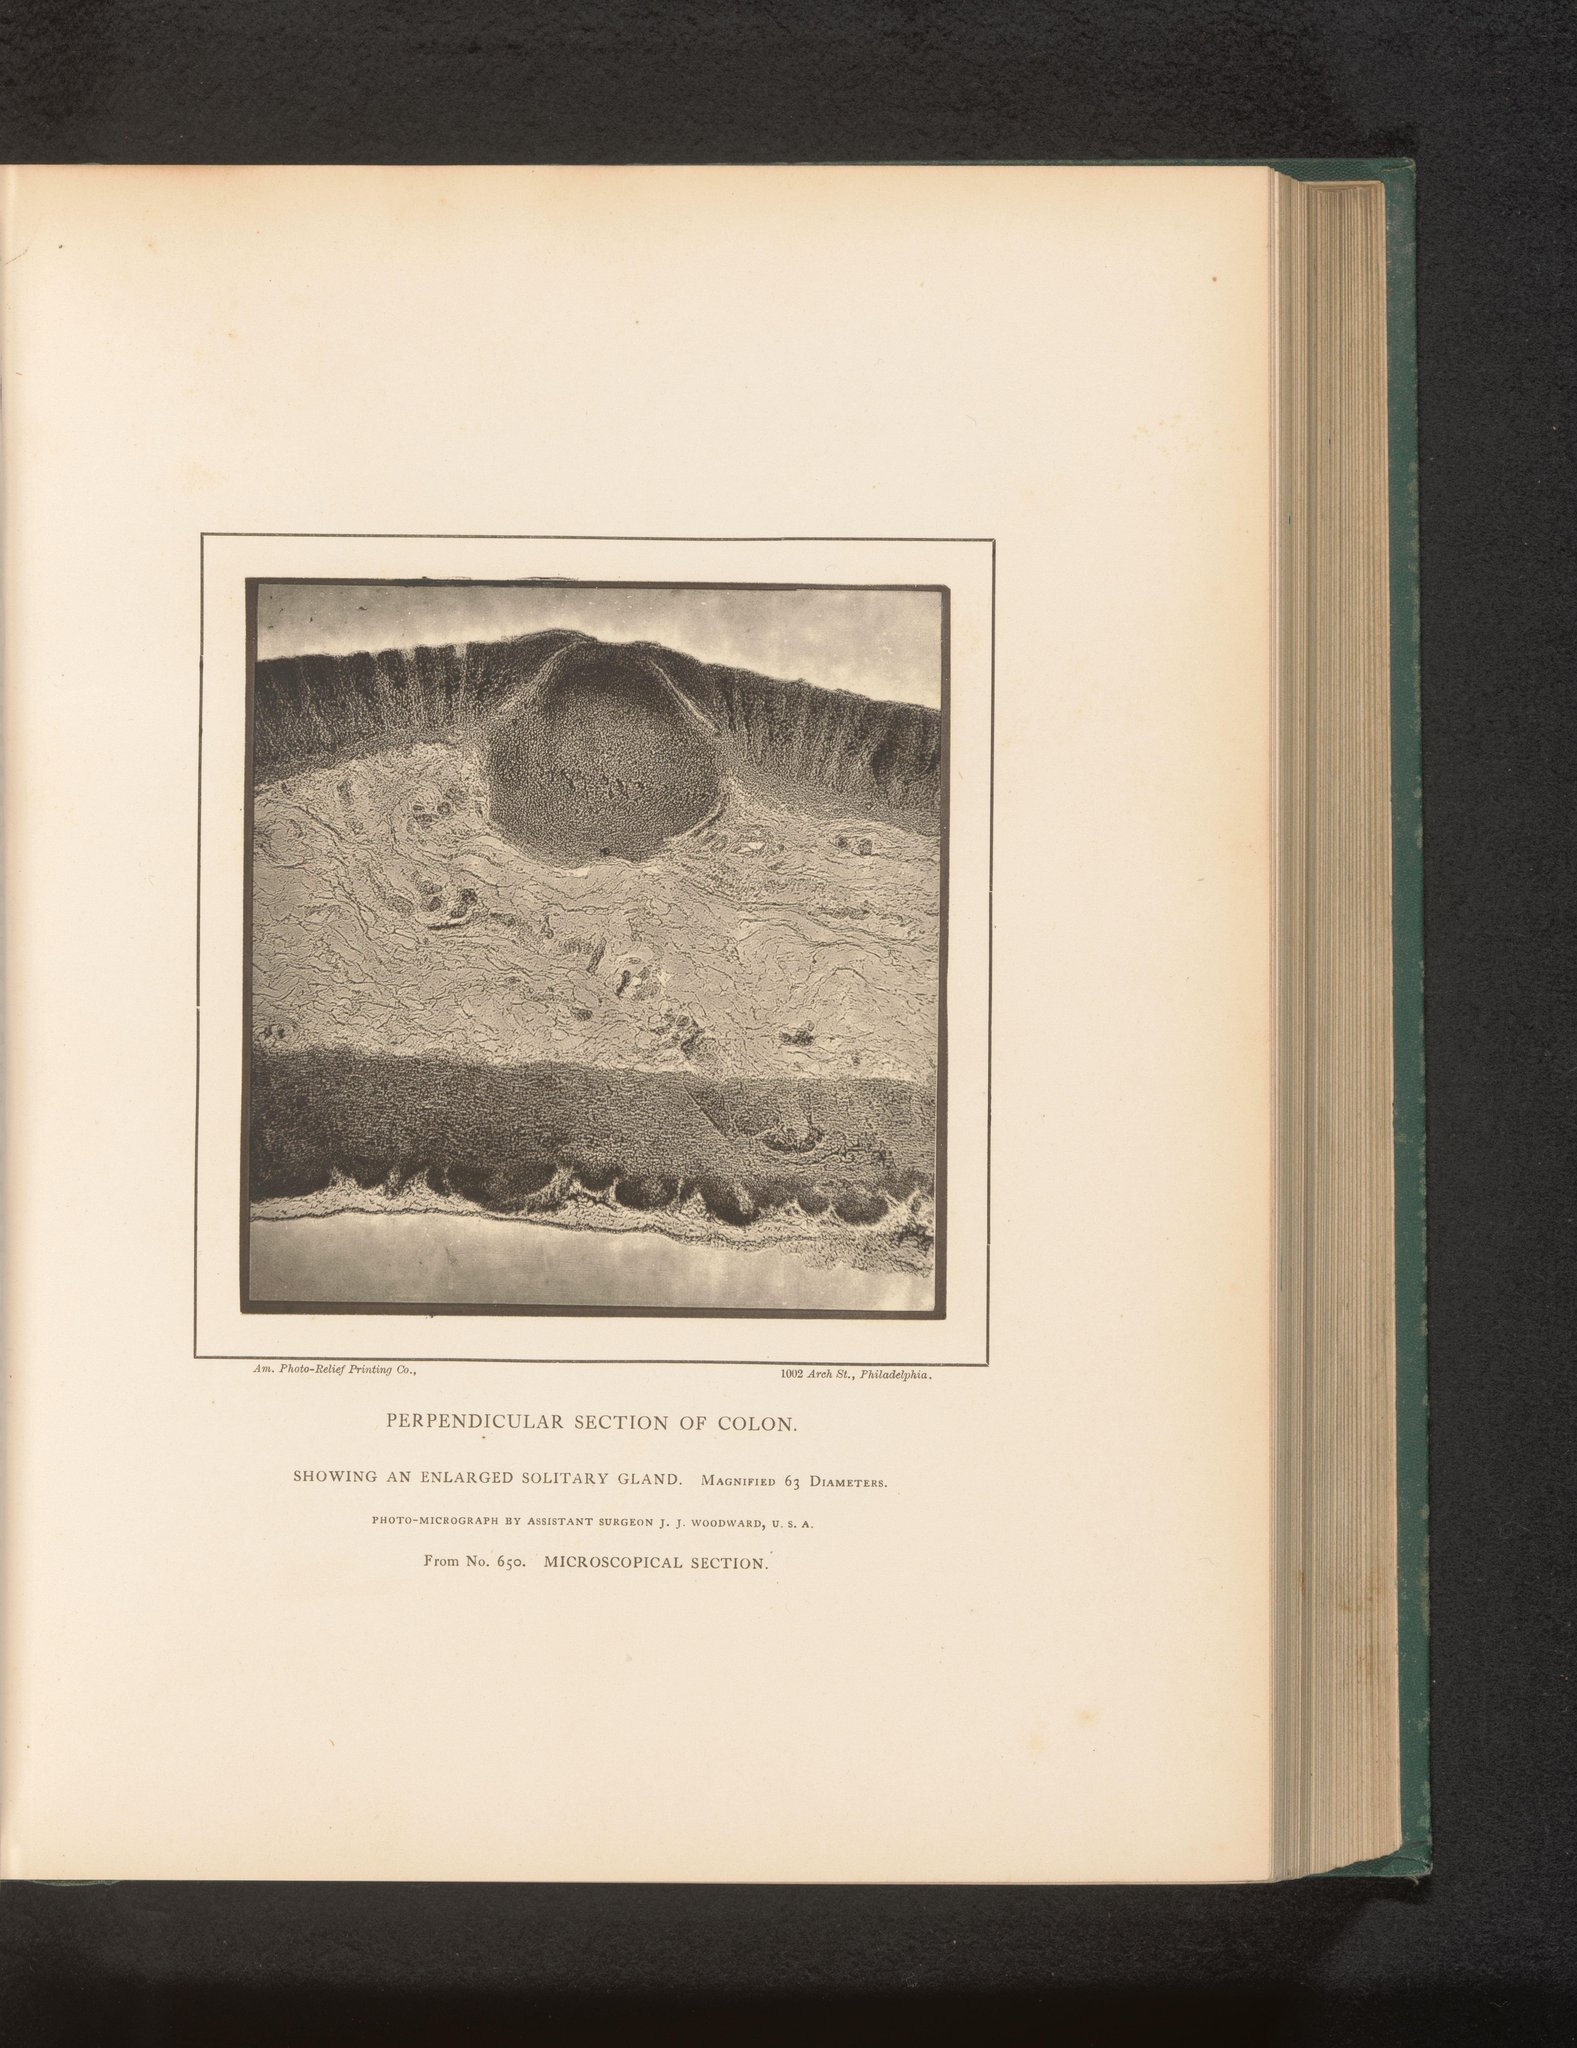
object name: page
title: Perpendicular Section of Colon Showing an Enlarged Solitary Gland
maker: joseph janvier woodward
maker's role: chirurg, fotograaf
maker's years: 1833-1884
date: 1874-1879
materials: paper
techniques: woodburytype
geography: philadelphia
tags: intestines, anatomical specimen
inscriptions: inscription: ‘Magnified 63 diameters./ Photo-micrograph by assistant surgeon J. J. Woodward, U. S. A./ From No. 650. MICROSCOPICAL SECTION.’, address: ‘1002 Arch St., Philadelphia’